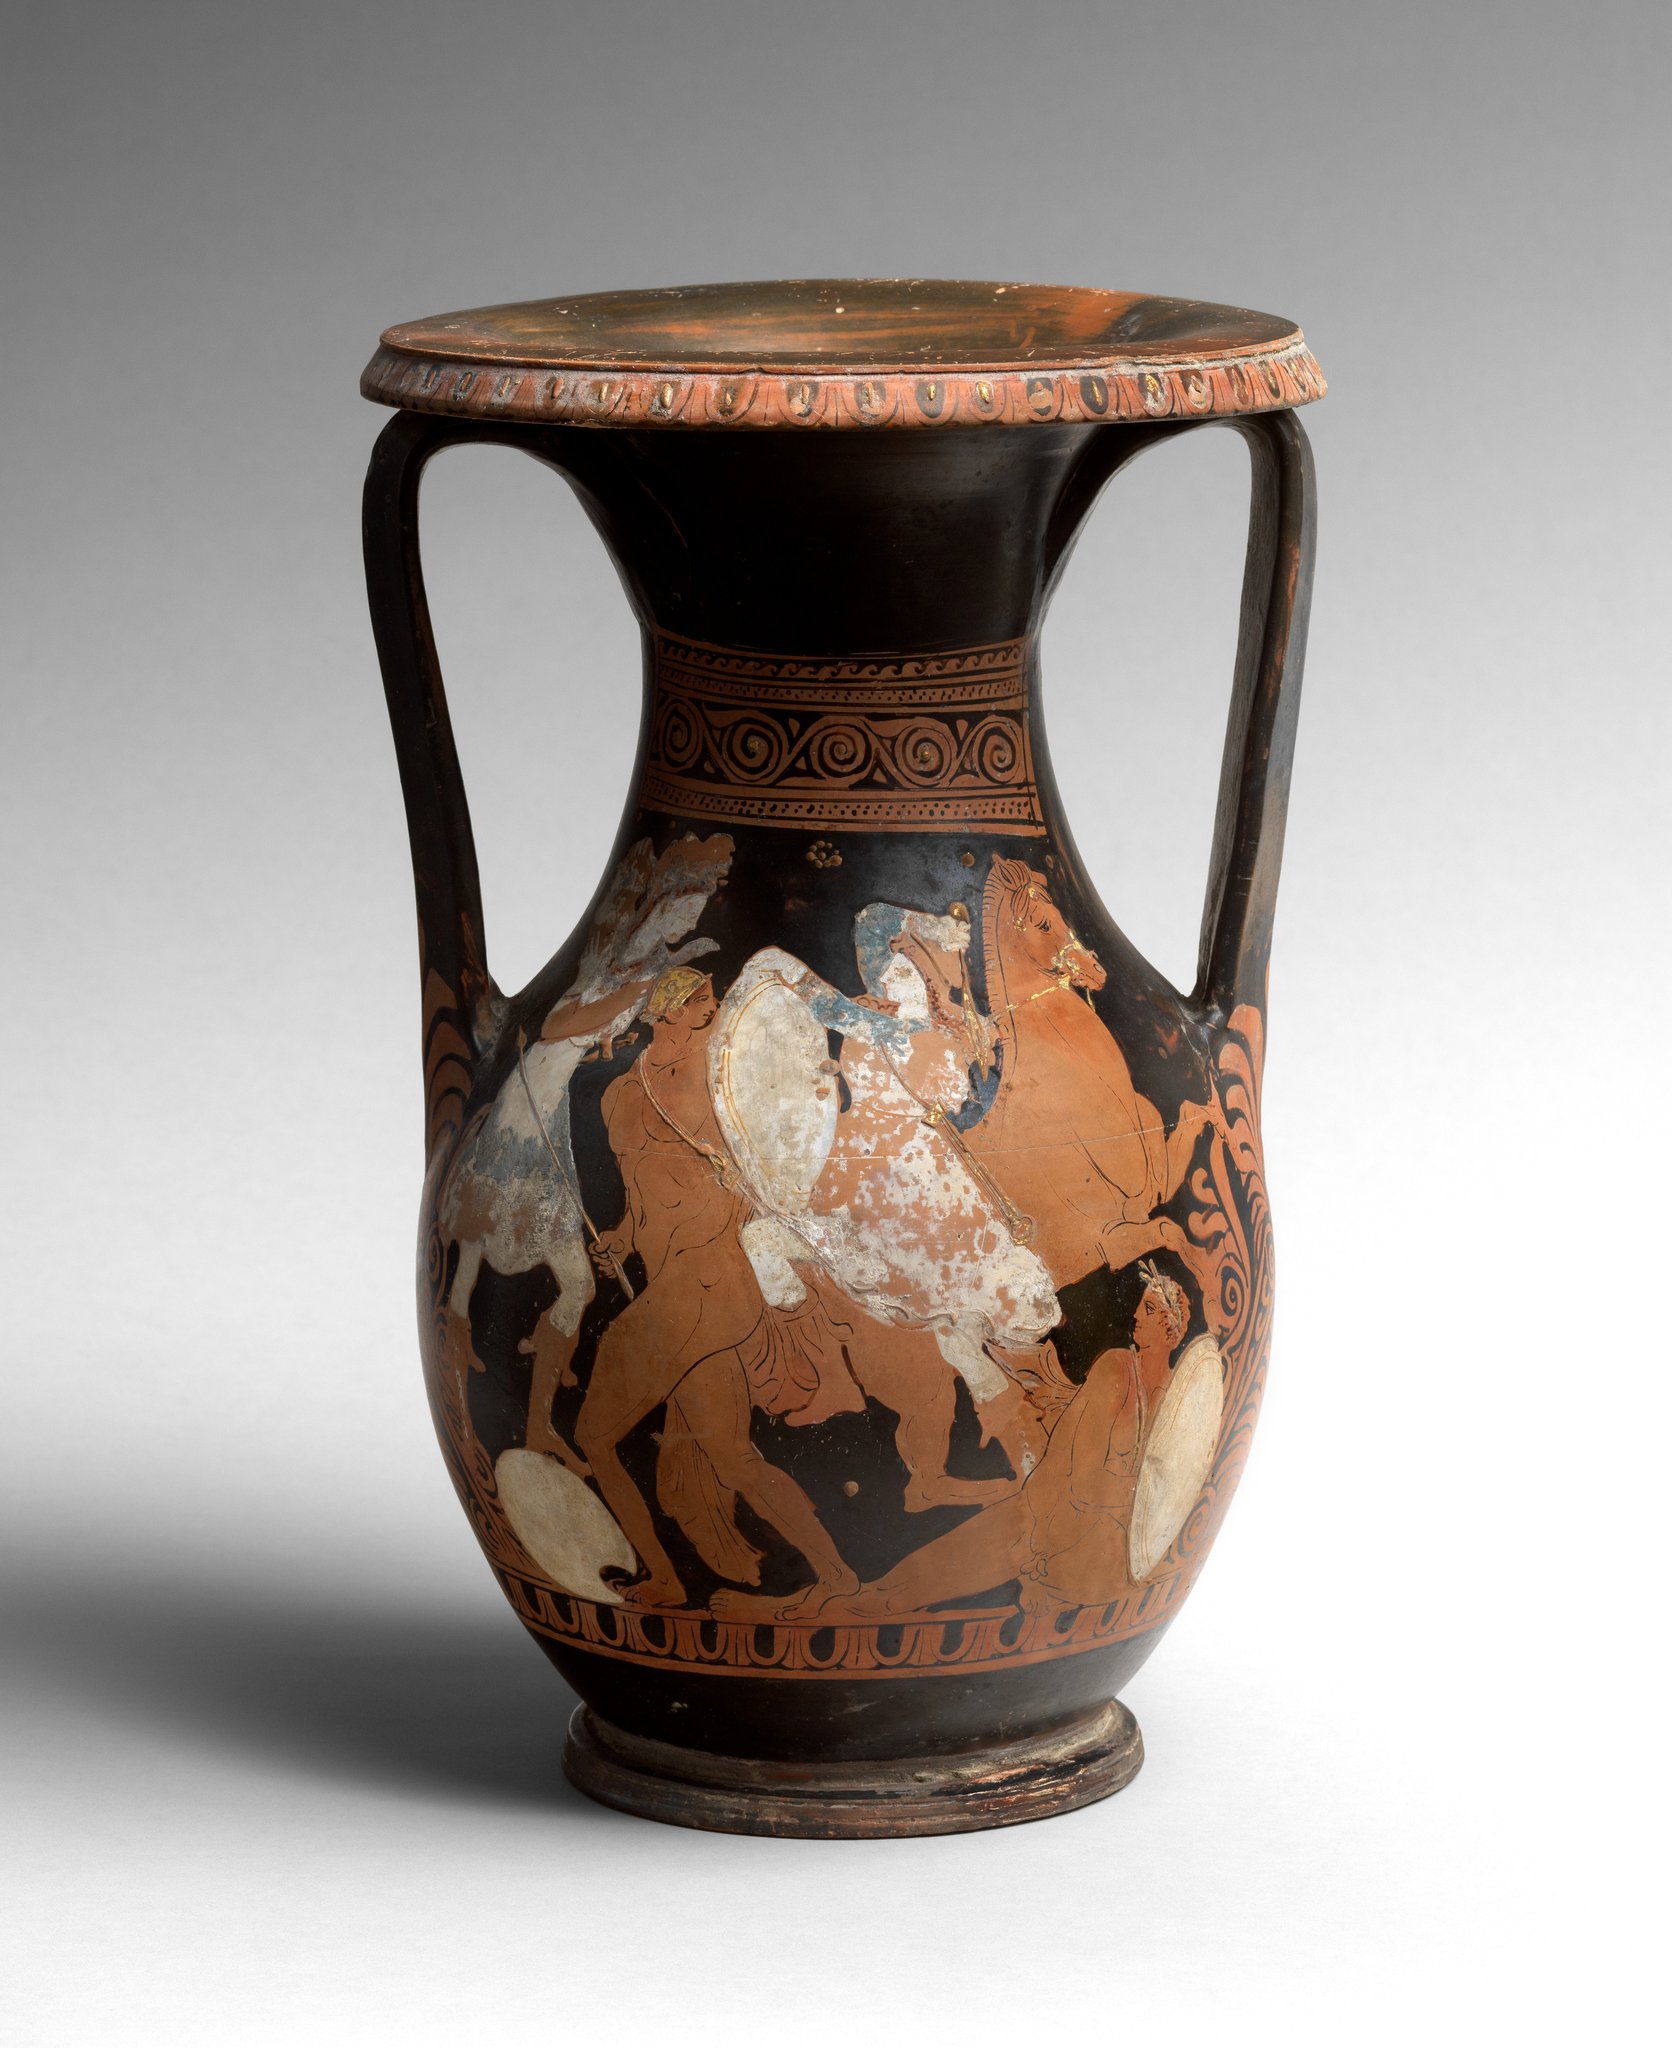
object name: pelike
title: Terracotta pelike (wine jar)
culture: greek, attic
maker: amazon painter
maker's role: artist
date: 350-301 BCE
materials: terracotta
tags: men,amazons,maenads,satyrs,horses